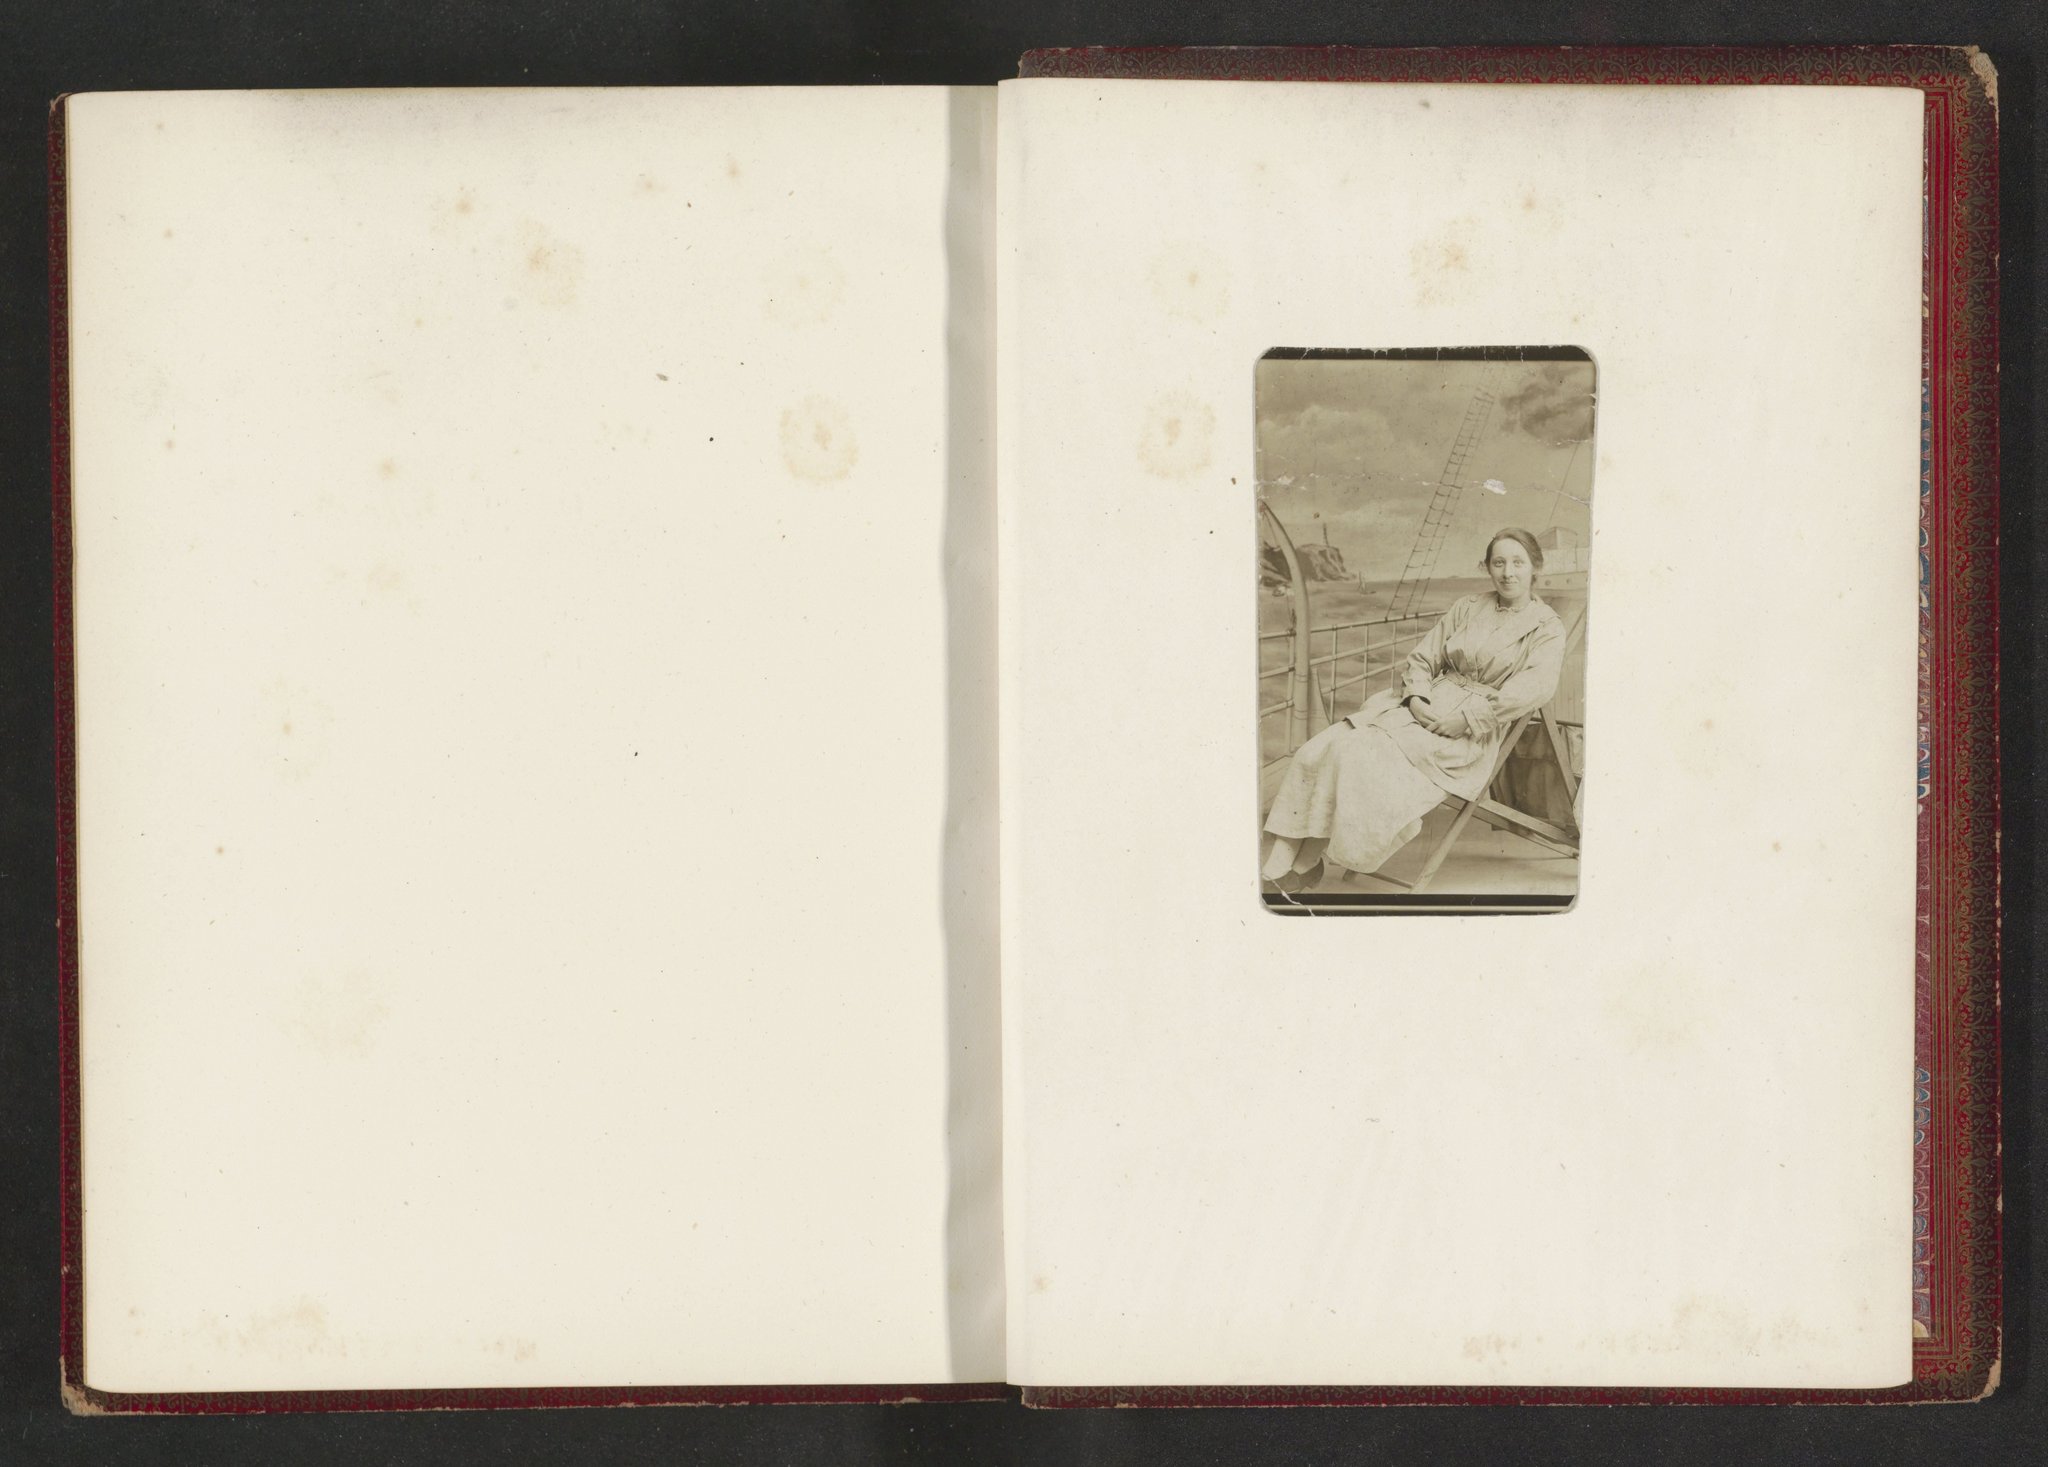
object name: photograph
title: Studioportret van een onbekende vrouw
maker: Anonymous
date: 1880-1910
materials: photographic support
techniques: daylight paper print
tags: studio ~ photographer, adult woman, studio requisites ~ photographer